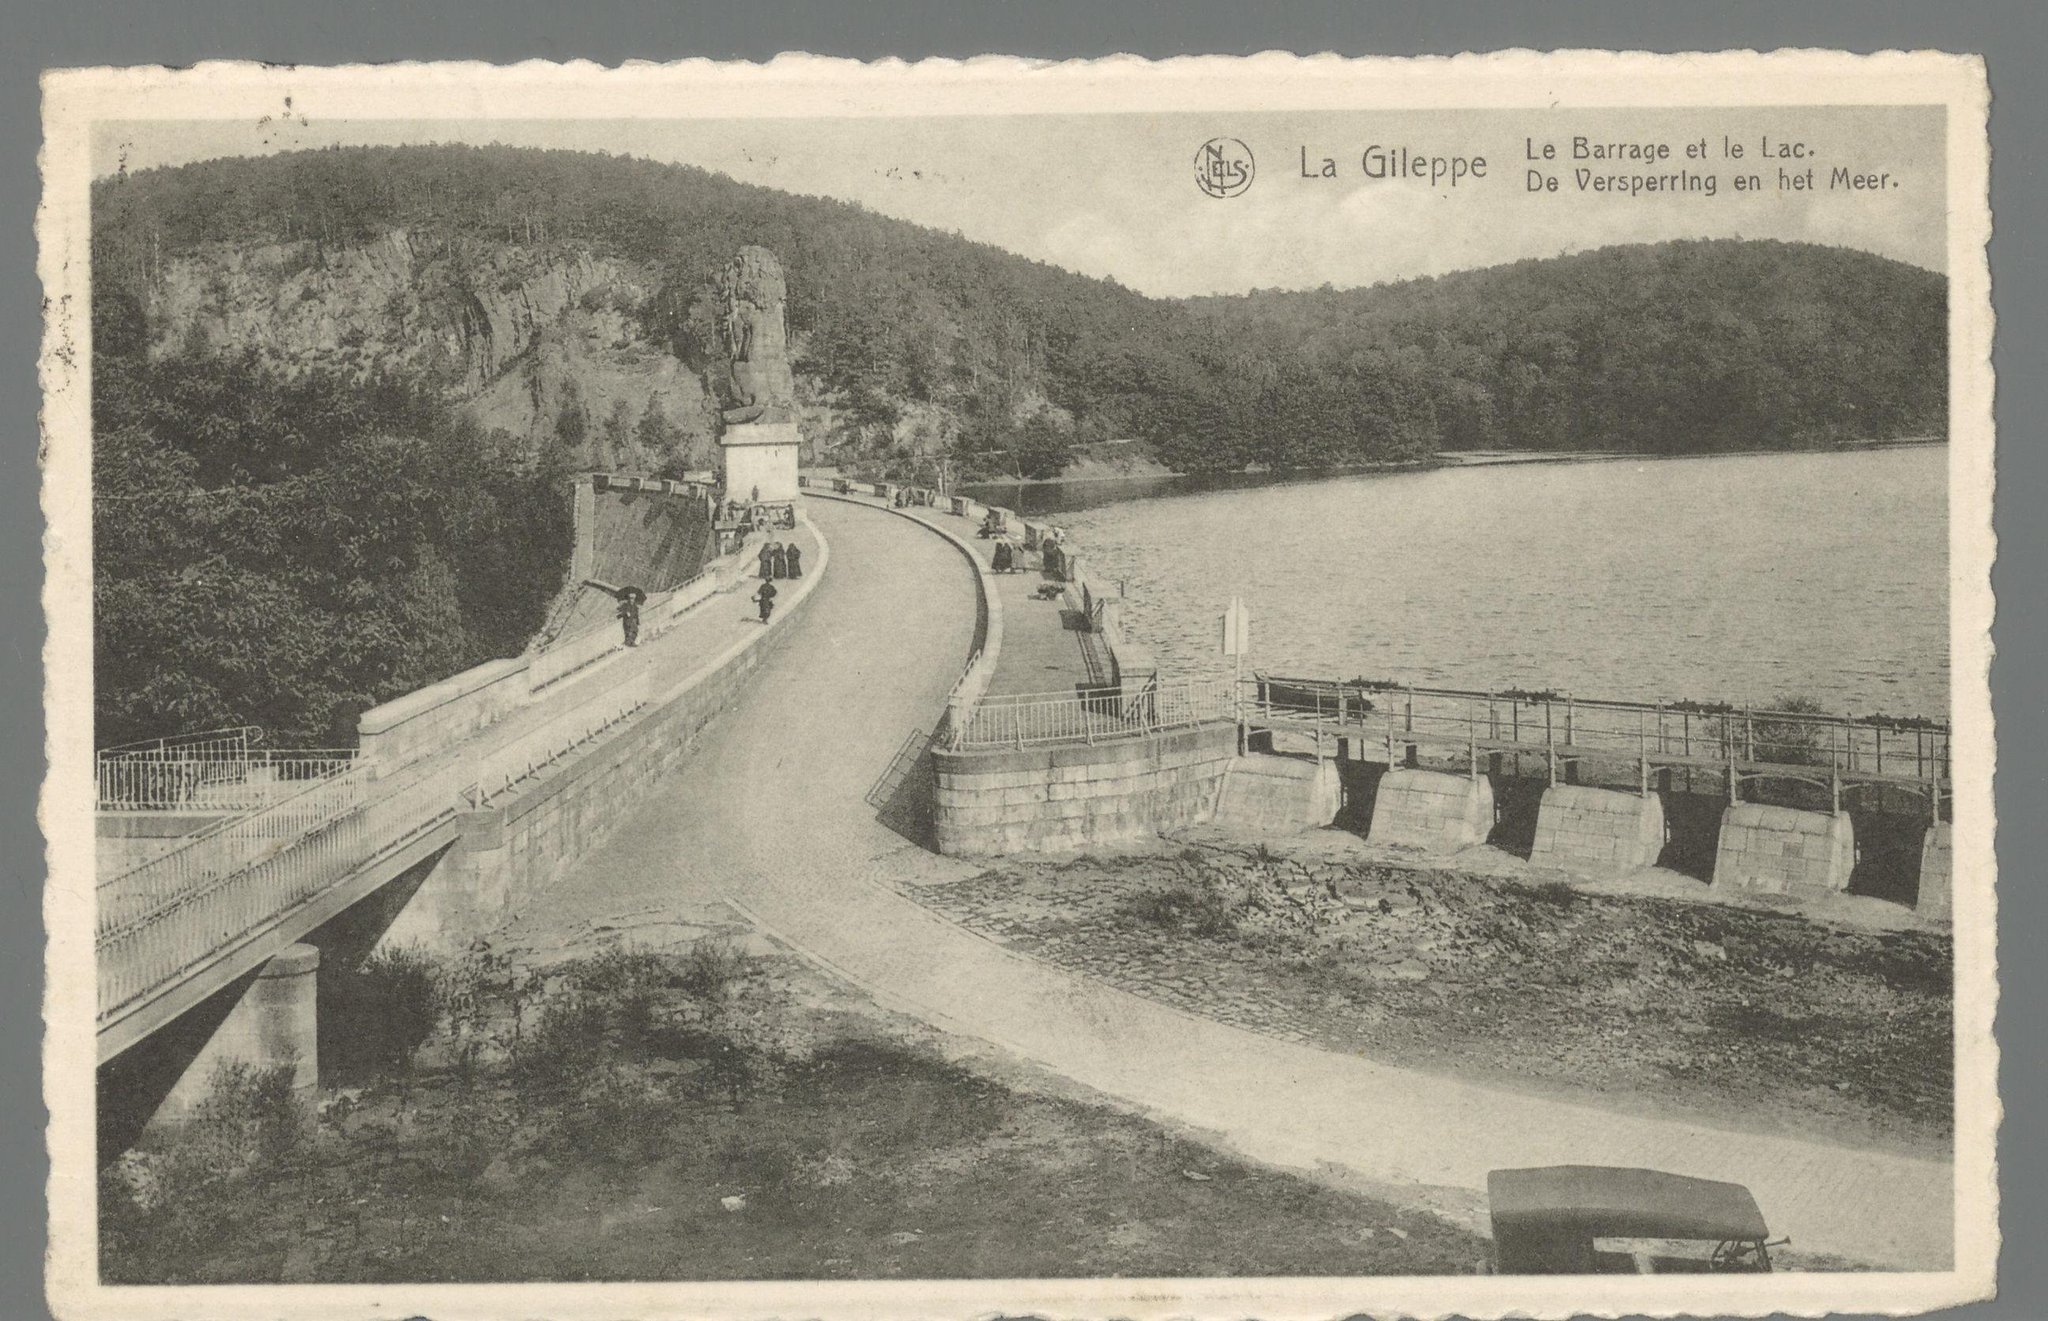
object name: photomechanical print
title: La Gileppe. Le Barrage et le Lac / De Versperring en het Meer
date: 1907-1913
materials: cardboard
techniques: photograph, writing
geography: brussels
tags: barrage, landscapes in the temperate zone (+ landscape with figures, staffage)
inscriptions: poststempel, verso, gestempeld